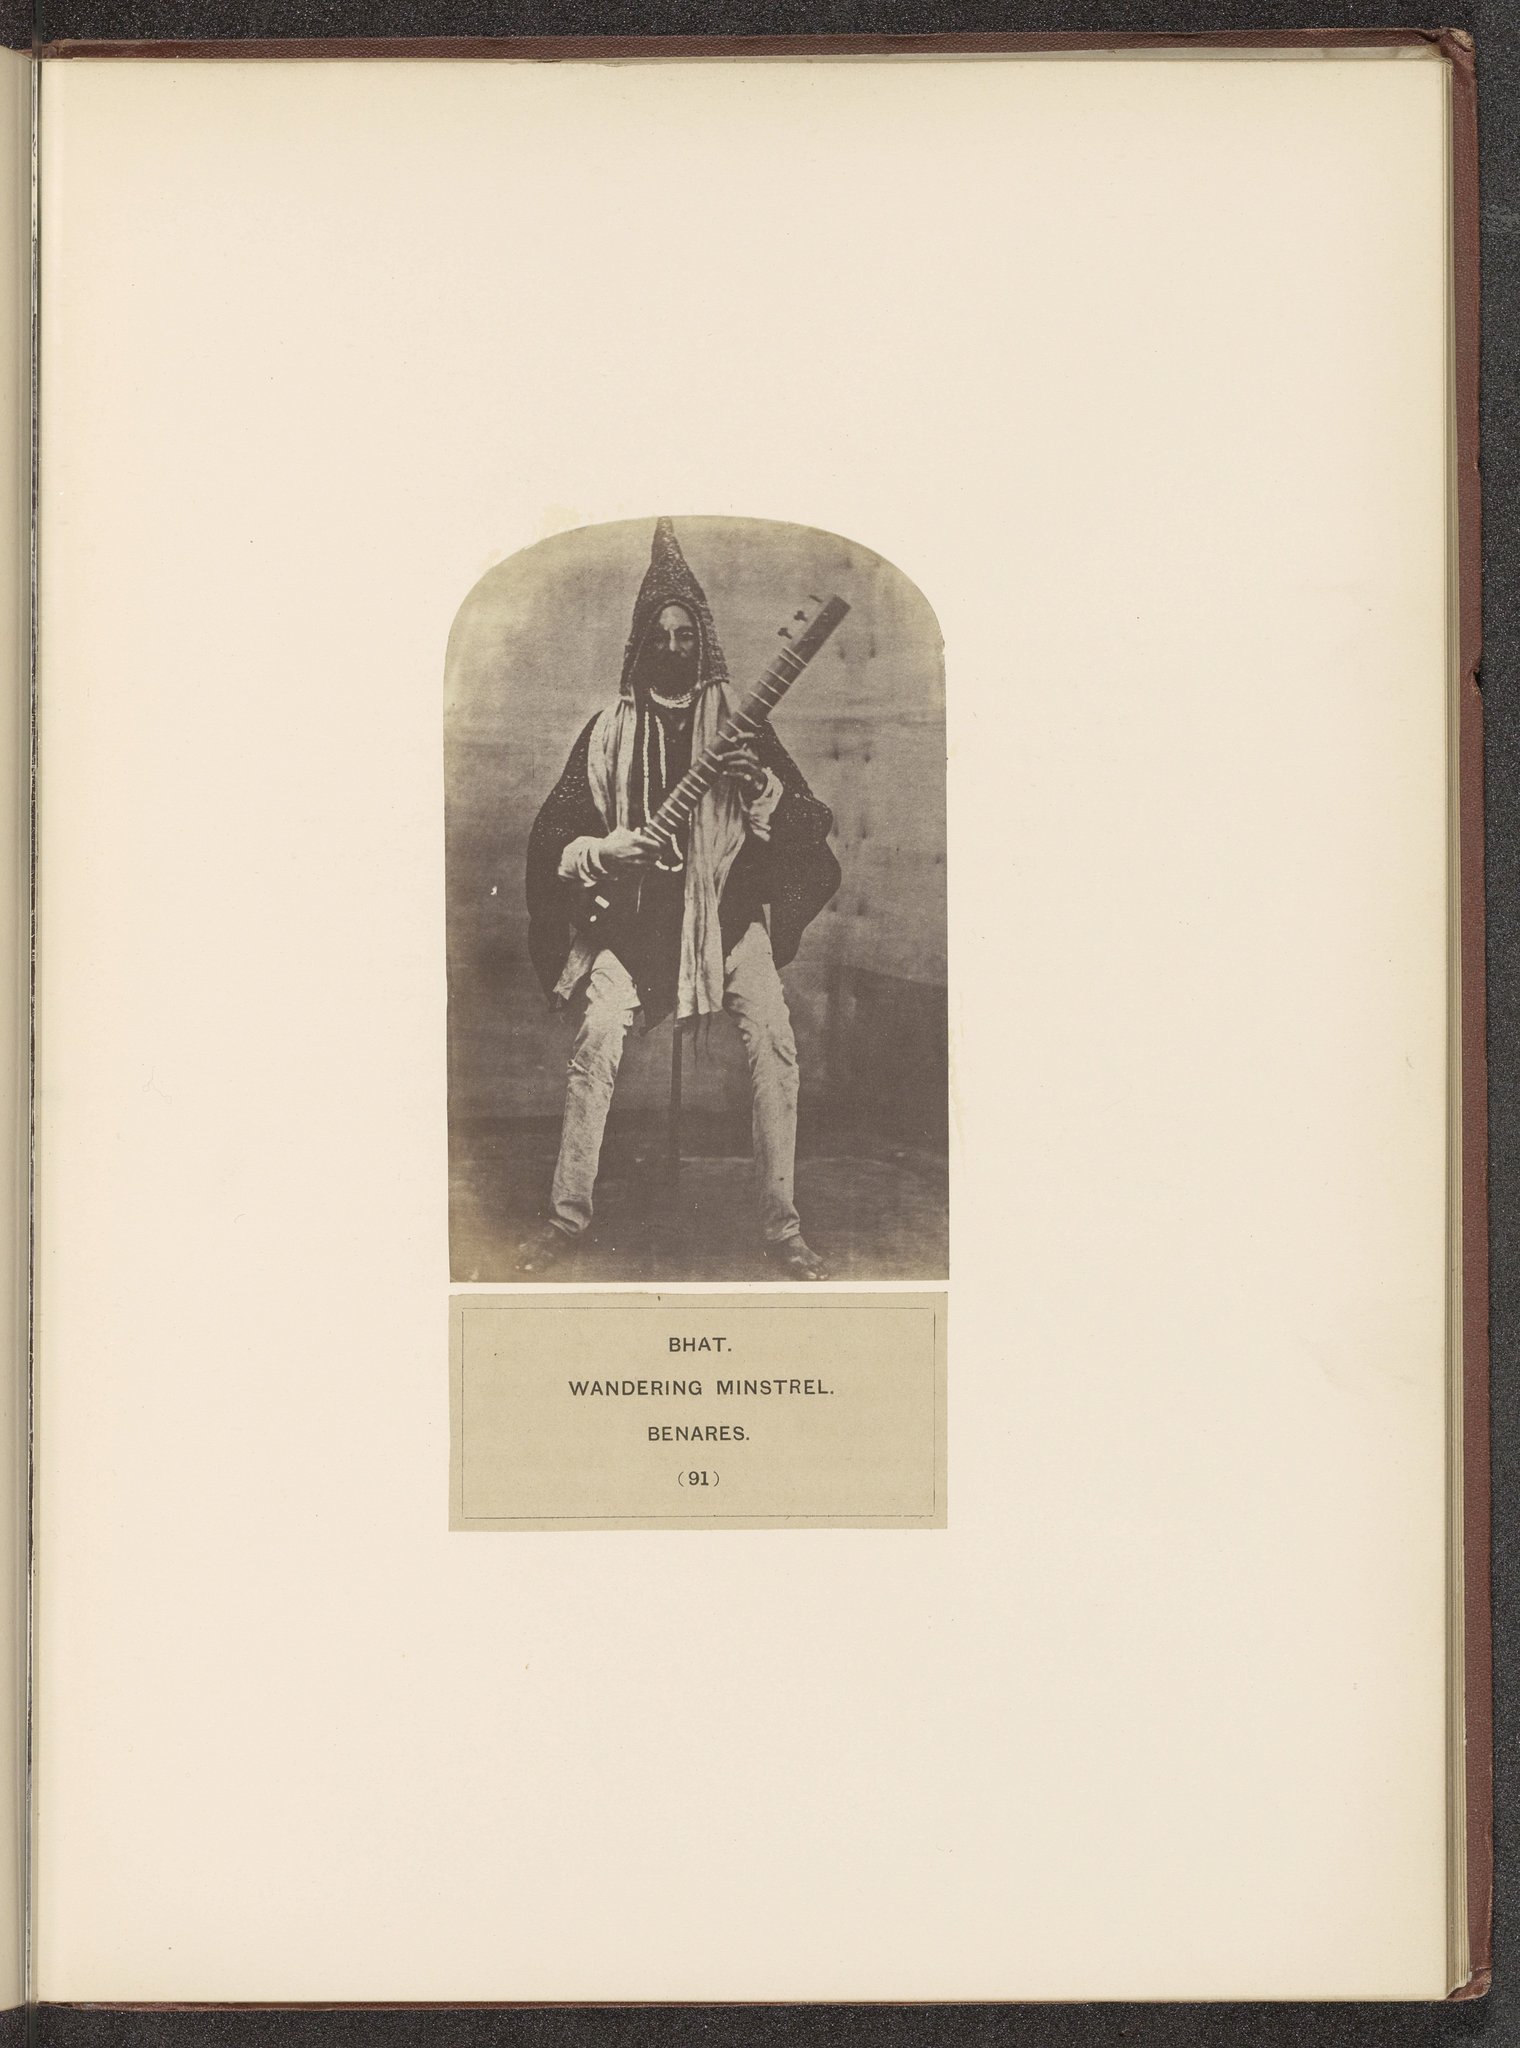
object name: photograph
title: Portrait of an unknown minstrel (Bhat) from Varanasi, Uttar Pradesh, India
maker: Anonymous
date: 1858-1868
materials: photographic support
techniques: albumen print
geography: varanasi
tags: minstrel, 'jongleur', human races; peoples; nationalities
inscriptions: inscription, q: ‘BHAT./ WANDERING MINSTREL./ BENARES.’, number: ‘(91)’